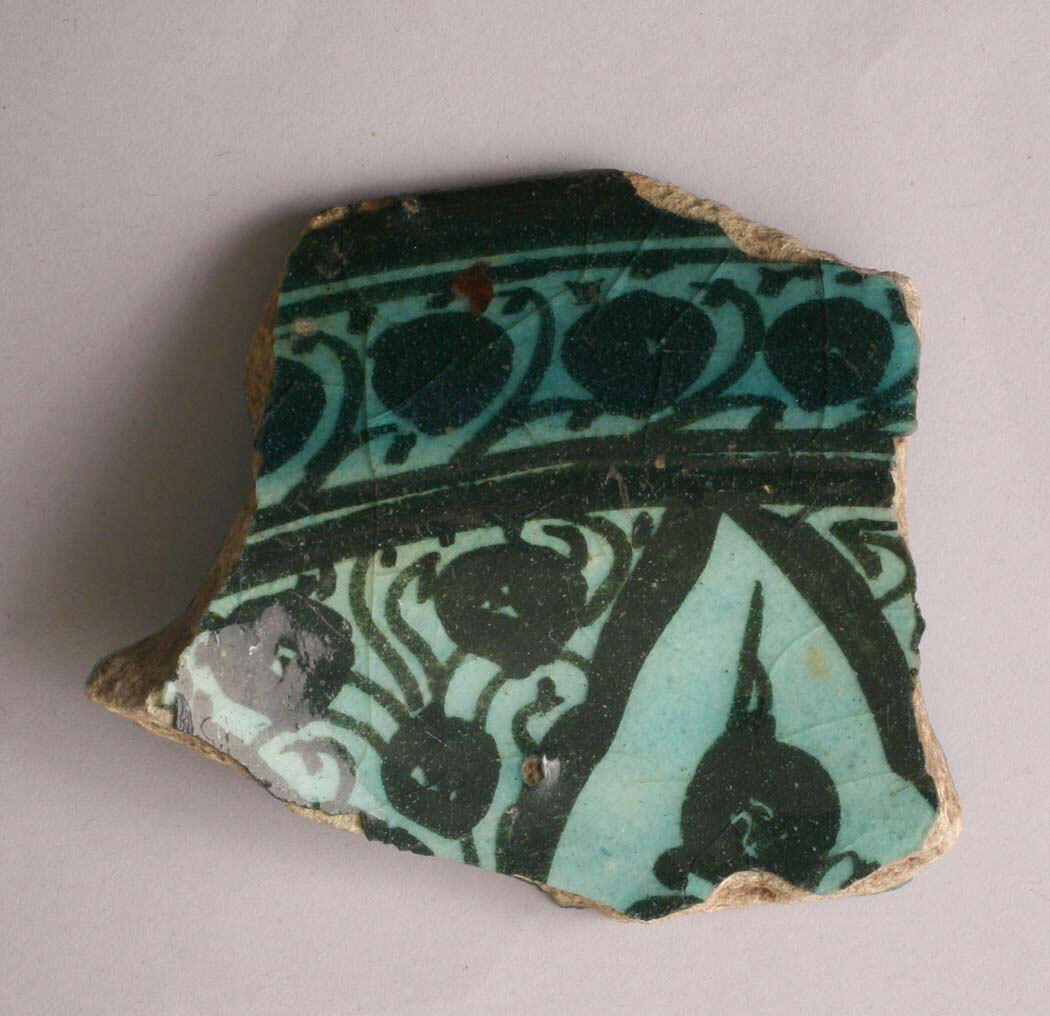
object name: fragment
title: Ceramic Fragment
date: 1301-1500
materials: glaze, stonepaste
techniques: painting, underglaze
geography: syria